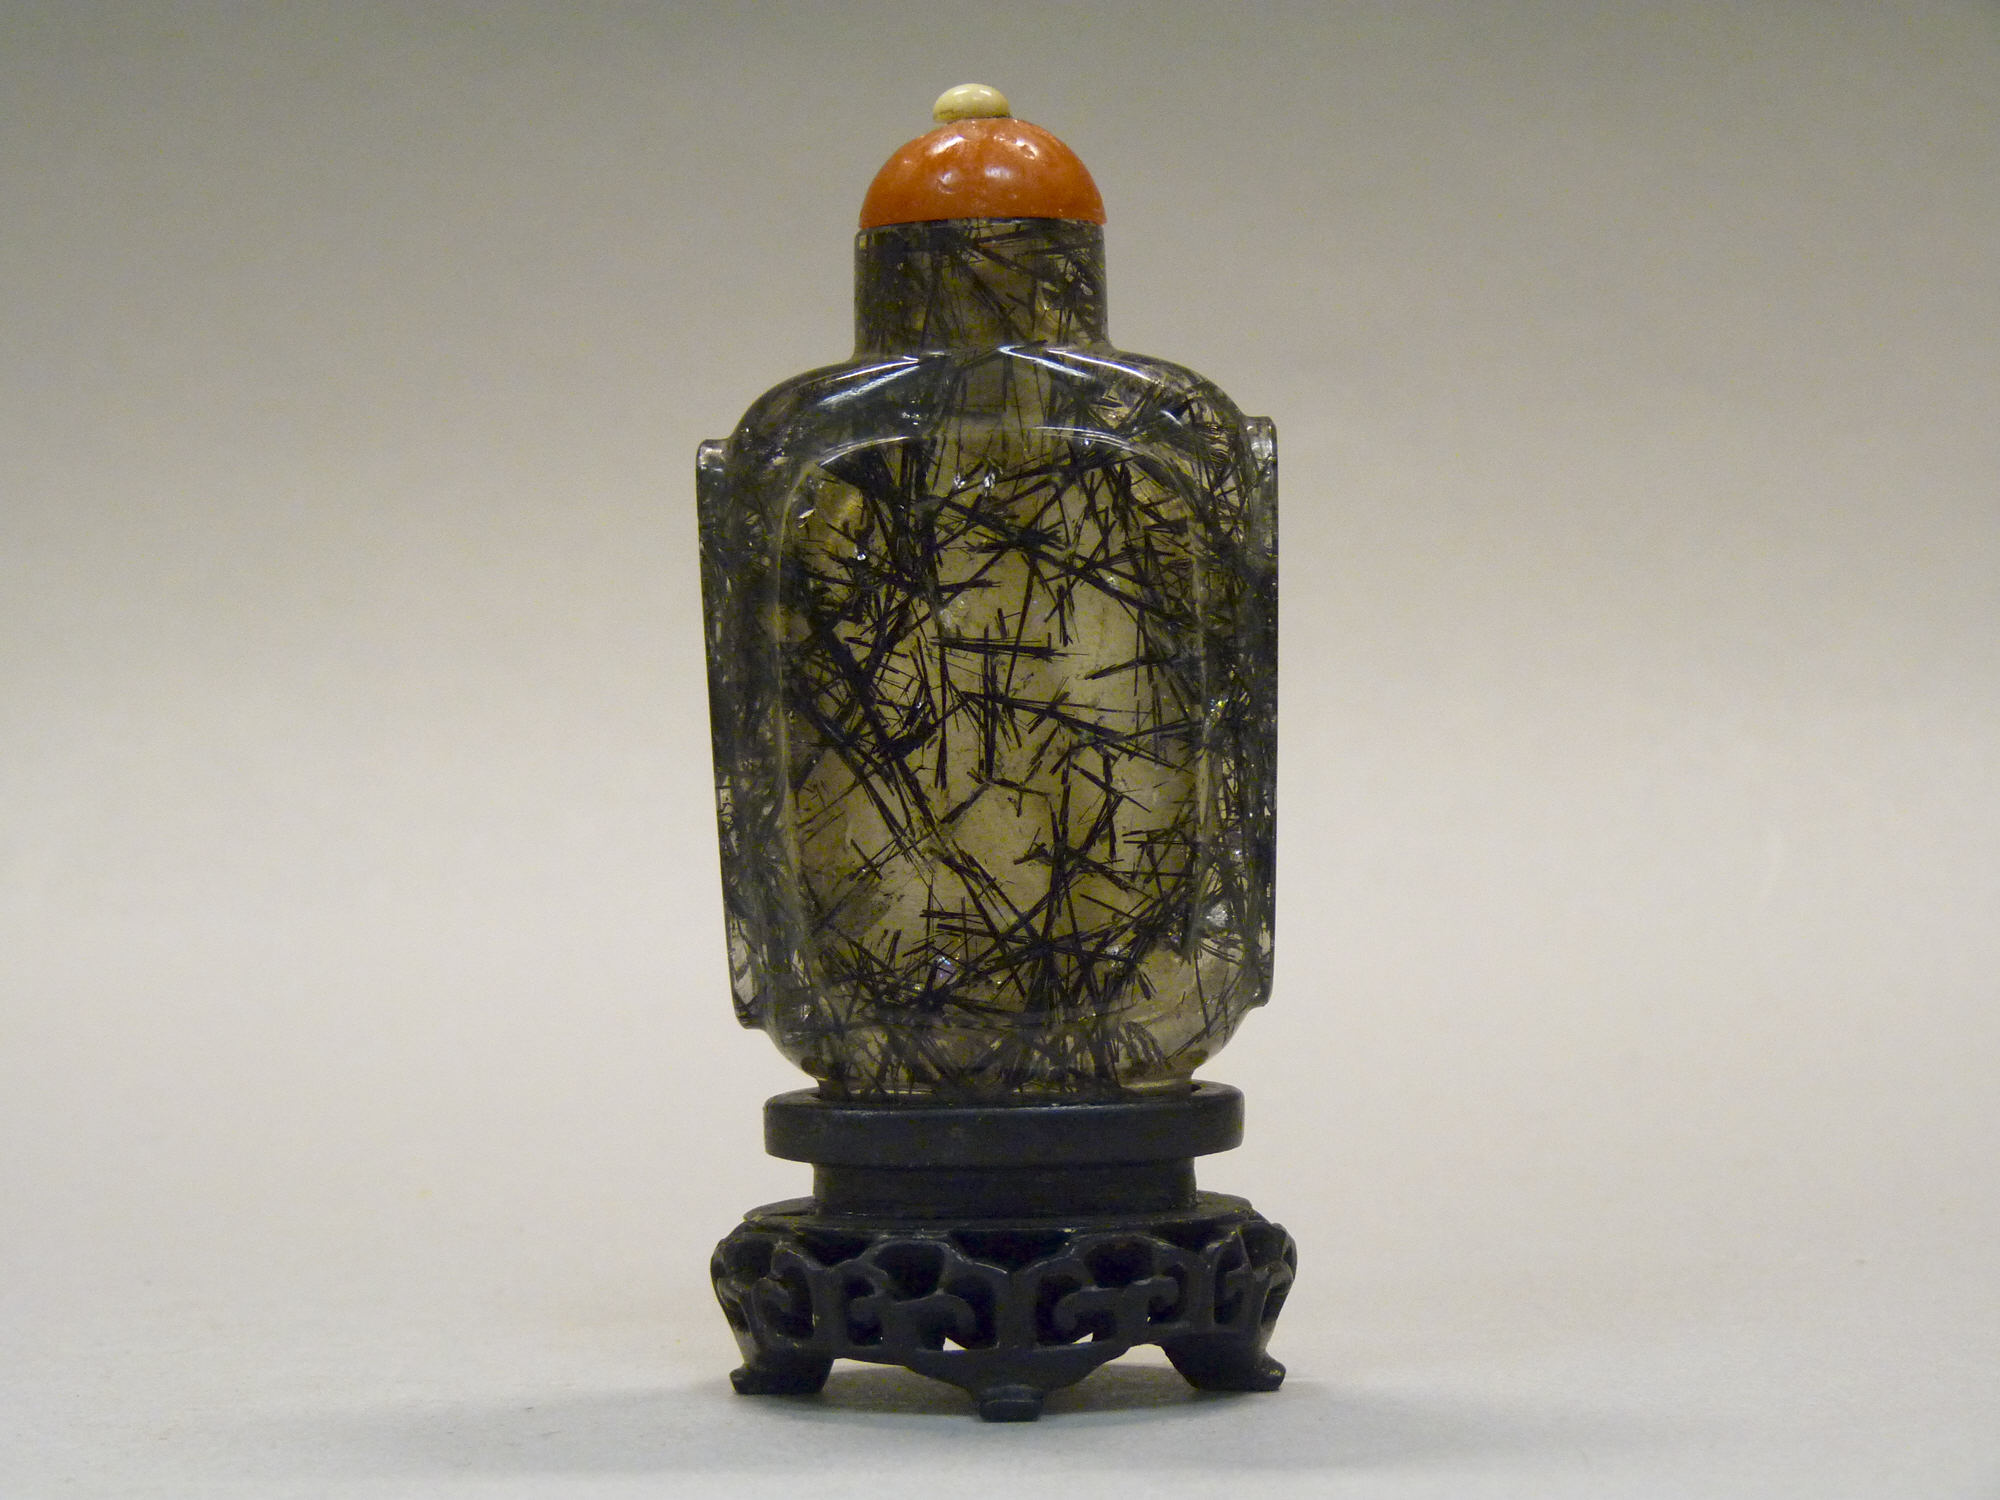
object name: snuff bottle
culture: chinese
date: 1801-1900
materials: crystal, glass, hair